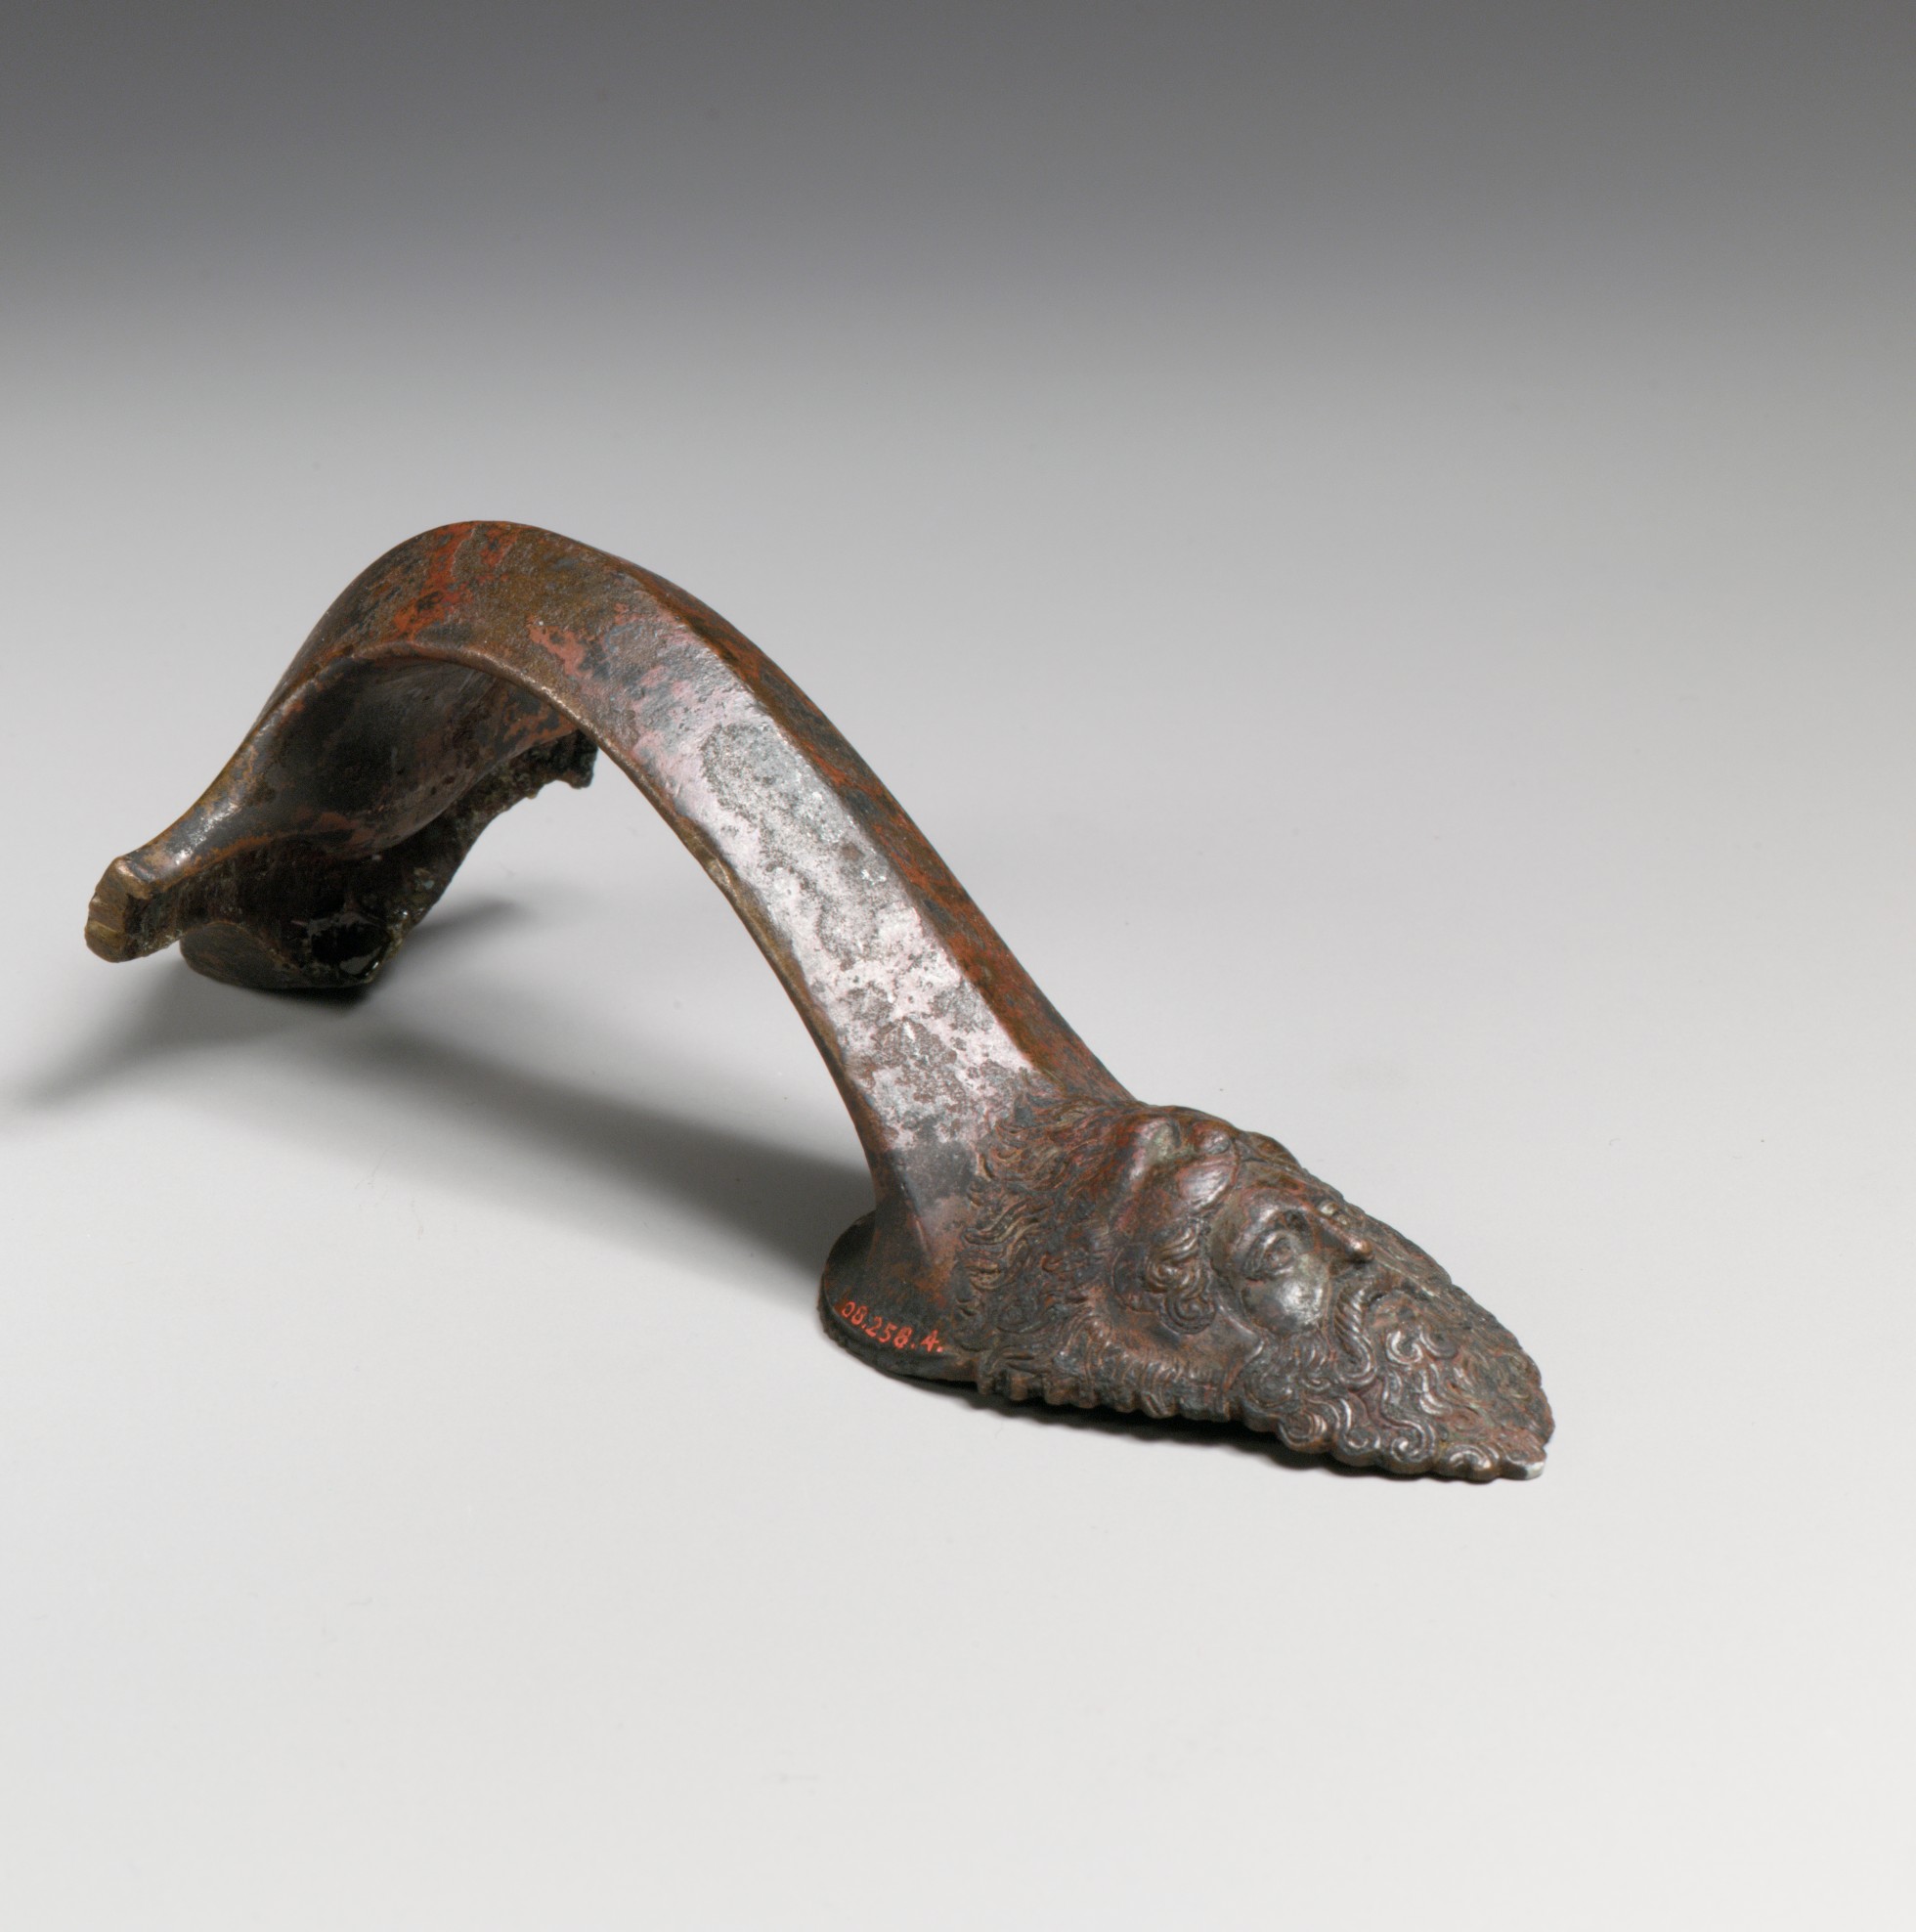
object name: handle with head of herakles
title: Bronze handle of an oinochoe (jug)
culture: greek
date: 425-400 BCE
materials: bronze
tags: heads